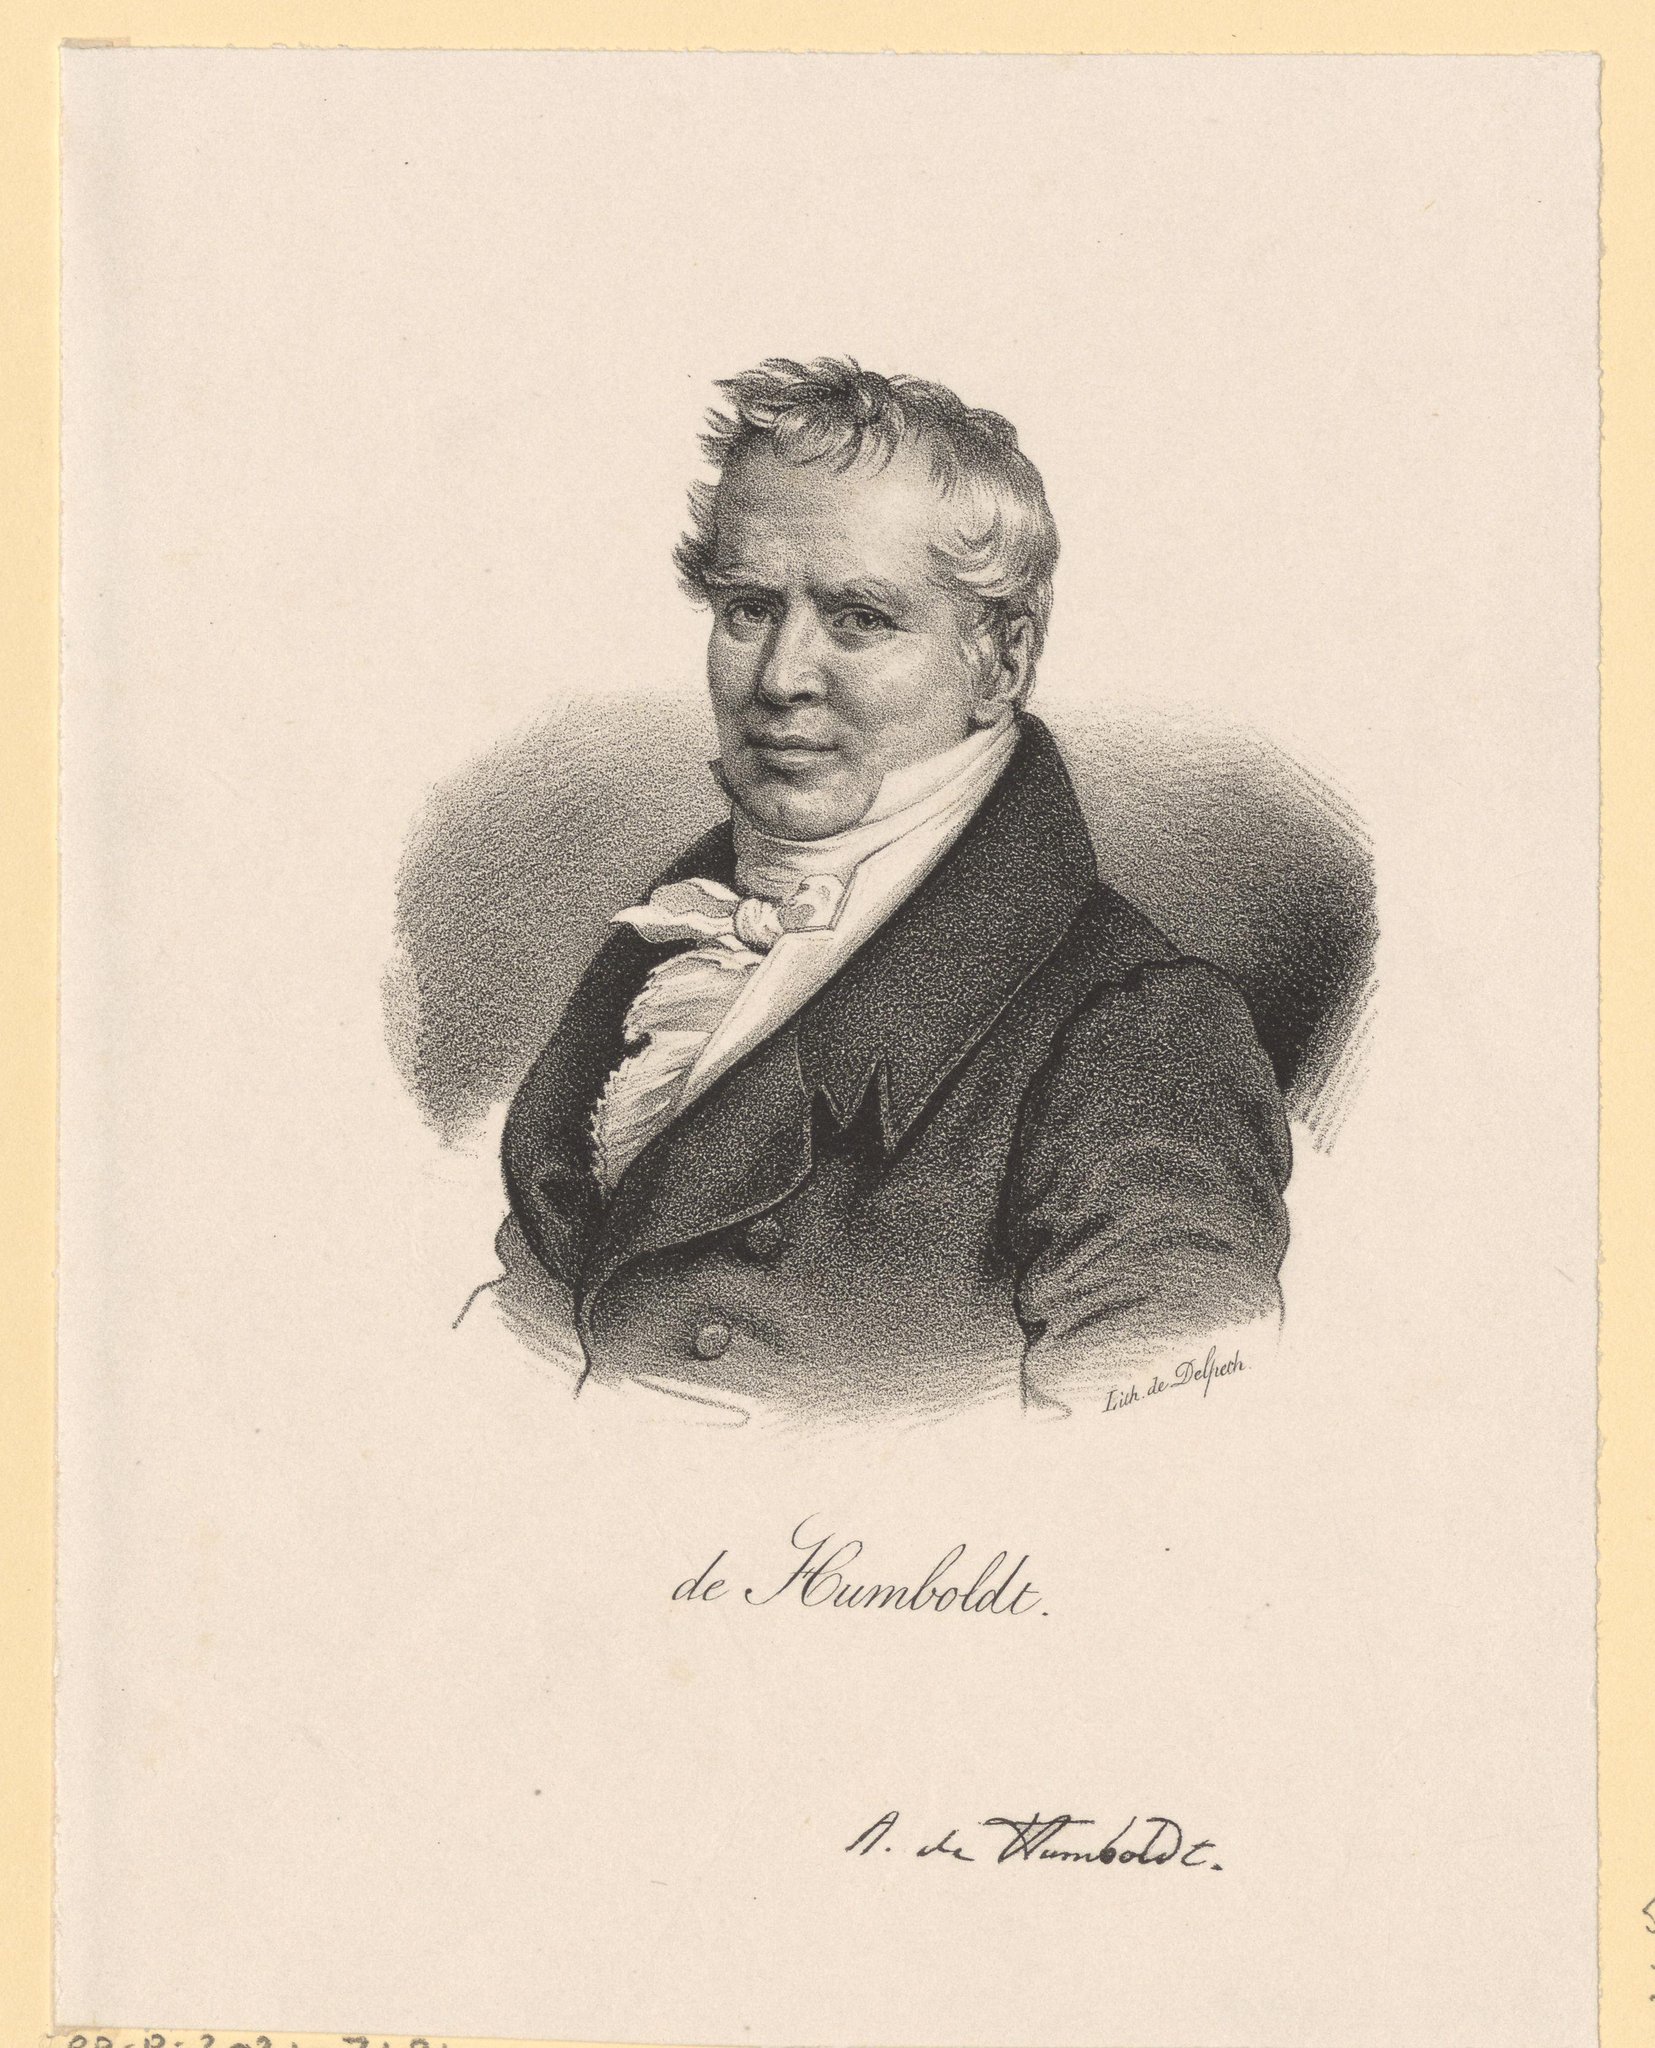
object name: print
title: Portret van Alexander von Humboldt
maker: Anonymous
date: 1818-1842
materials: paper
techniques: lithograph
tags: berlin, traveler, historical persons, biology (+ portrait of scholar, scientist)